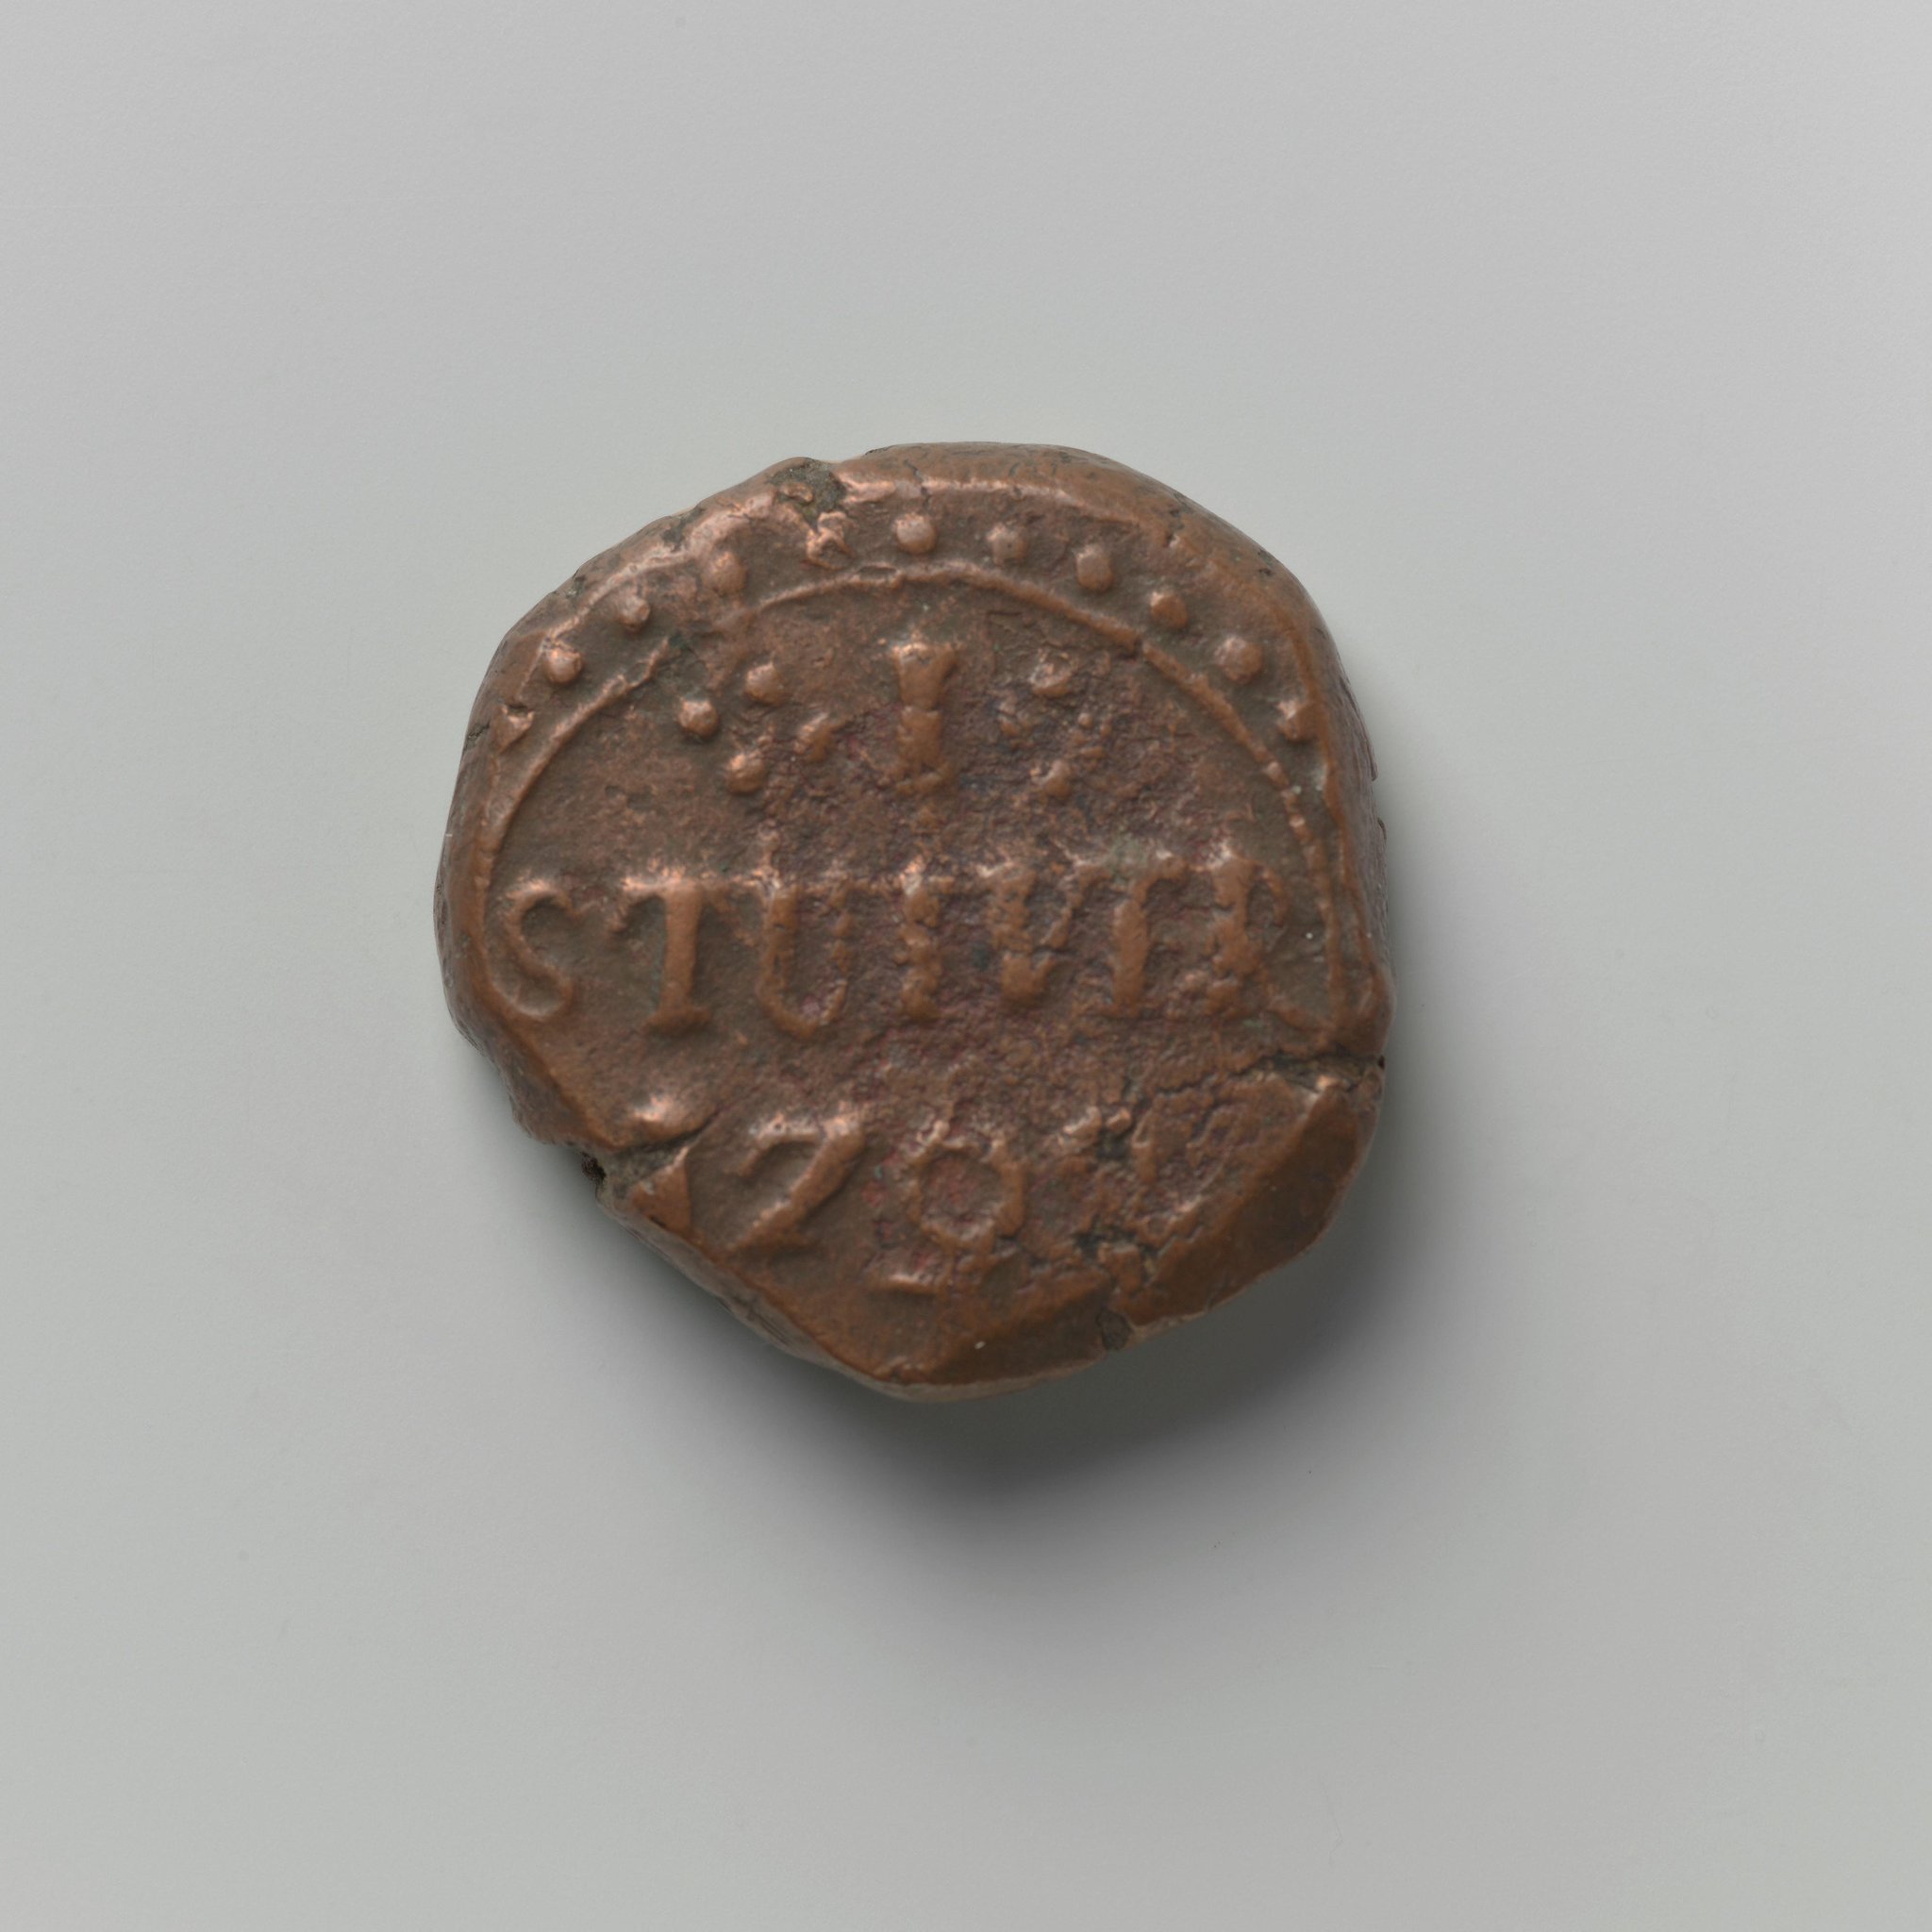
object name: coin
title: Stuiver van Ceylon, 1792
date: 1792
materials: copper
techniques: striking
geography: colombo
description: Koperen munt. Voorzijde: monogram van de VOC, waarboven letter C. Keerzijde:eenregelig opschrift: waarde-aanduiding stuiver, waarboven I en waaronder jaartal. Gladde rand.